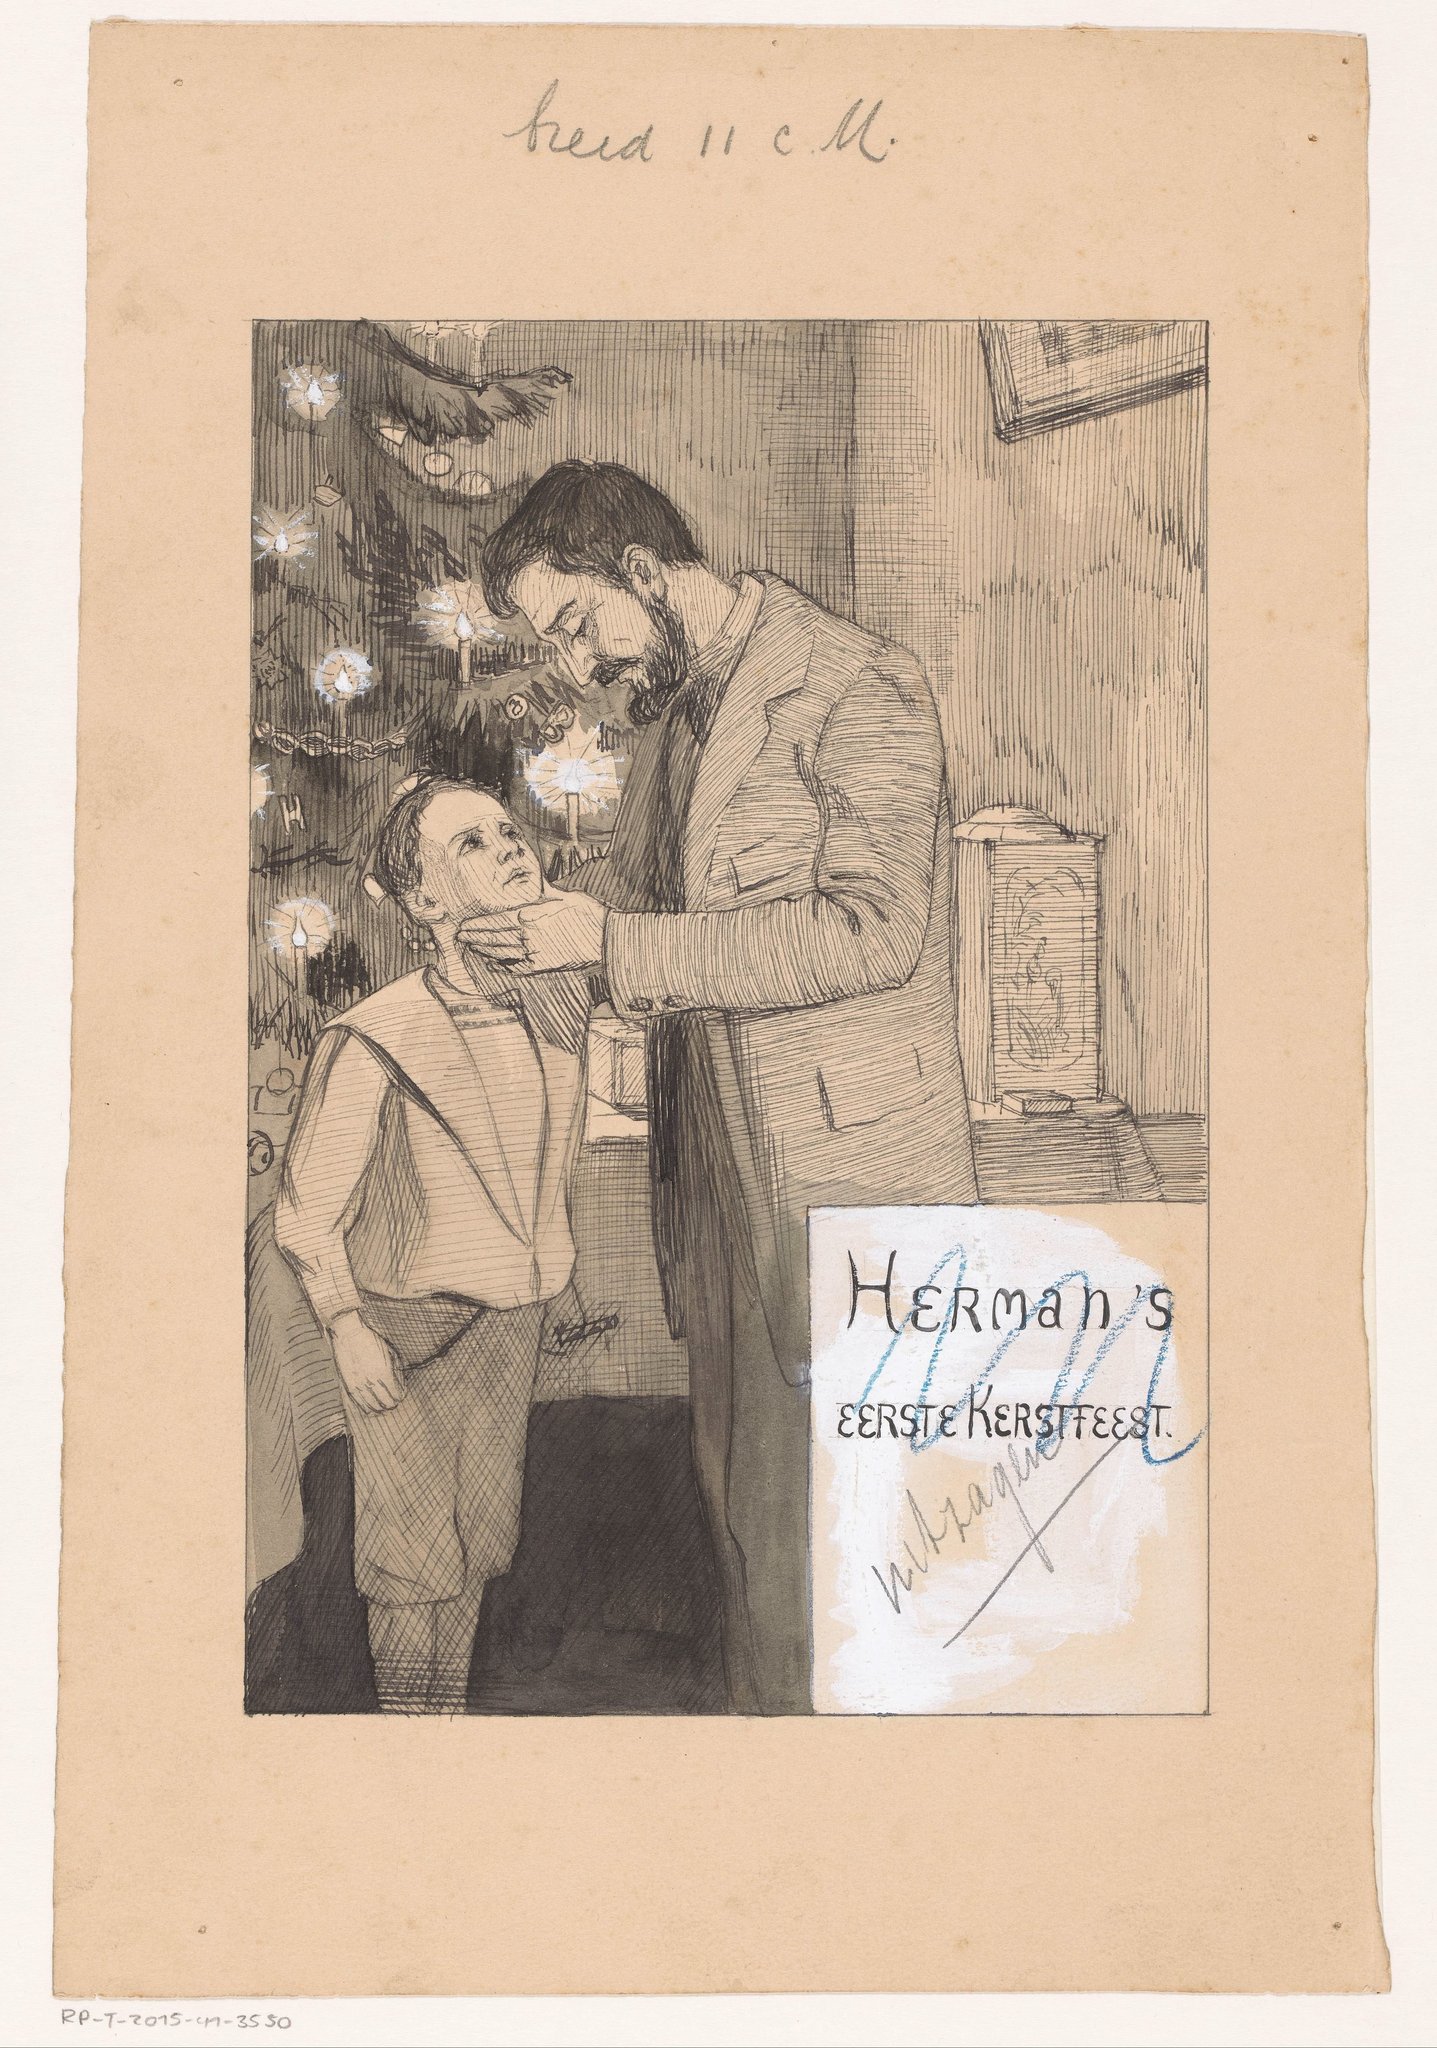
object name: drawing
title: Bandontwerp voor: A.C.L., Herman's eerste kerstfeest, c. 1898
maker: Anonymous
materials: chalk, paint, ink, paper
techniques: brush, pen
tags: christmas tree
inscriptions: collector's mark: Lugt 2228a, :, annotation: ‘uitzagen’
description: Een man en jongen staan bij een versierde en verlichte kerstboom in een kamer. De man pakt de kin van de jongen vast met zijn linkerhand.